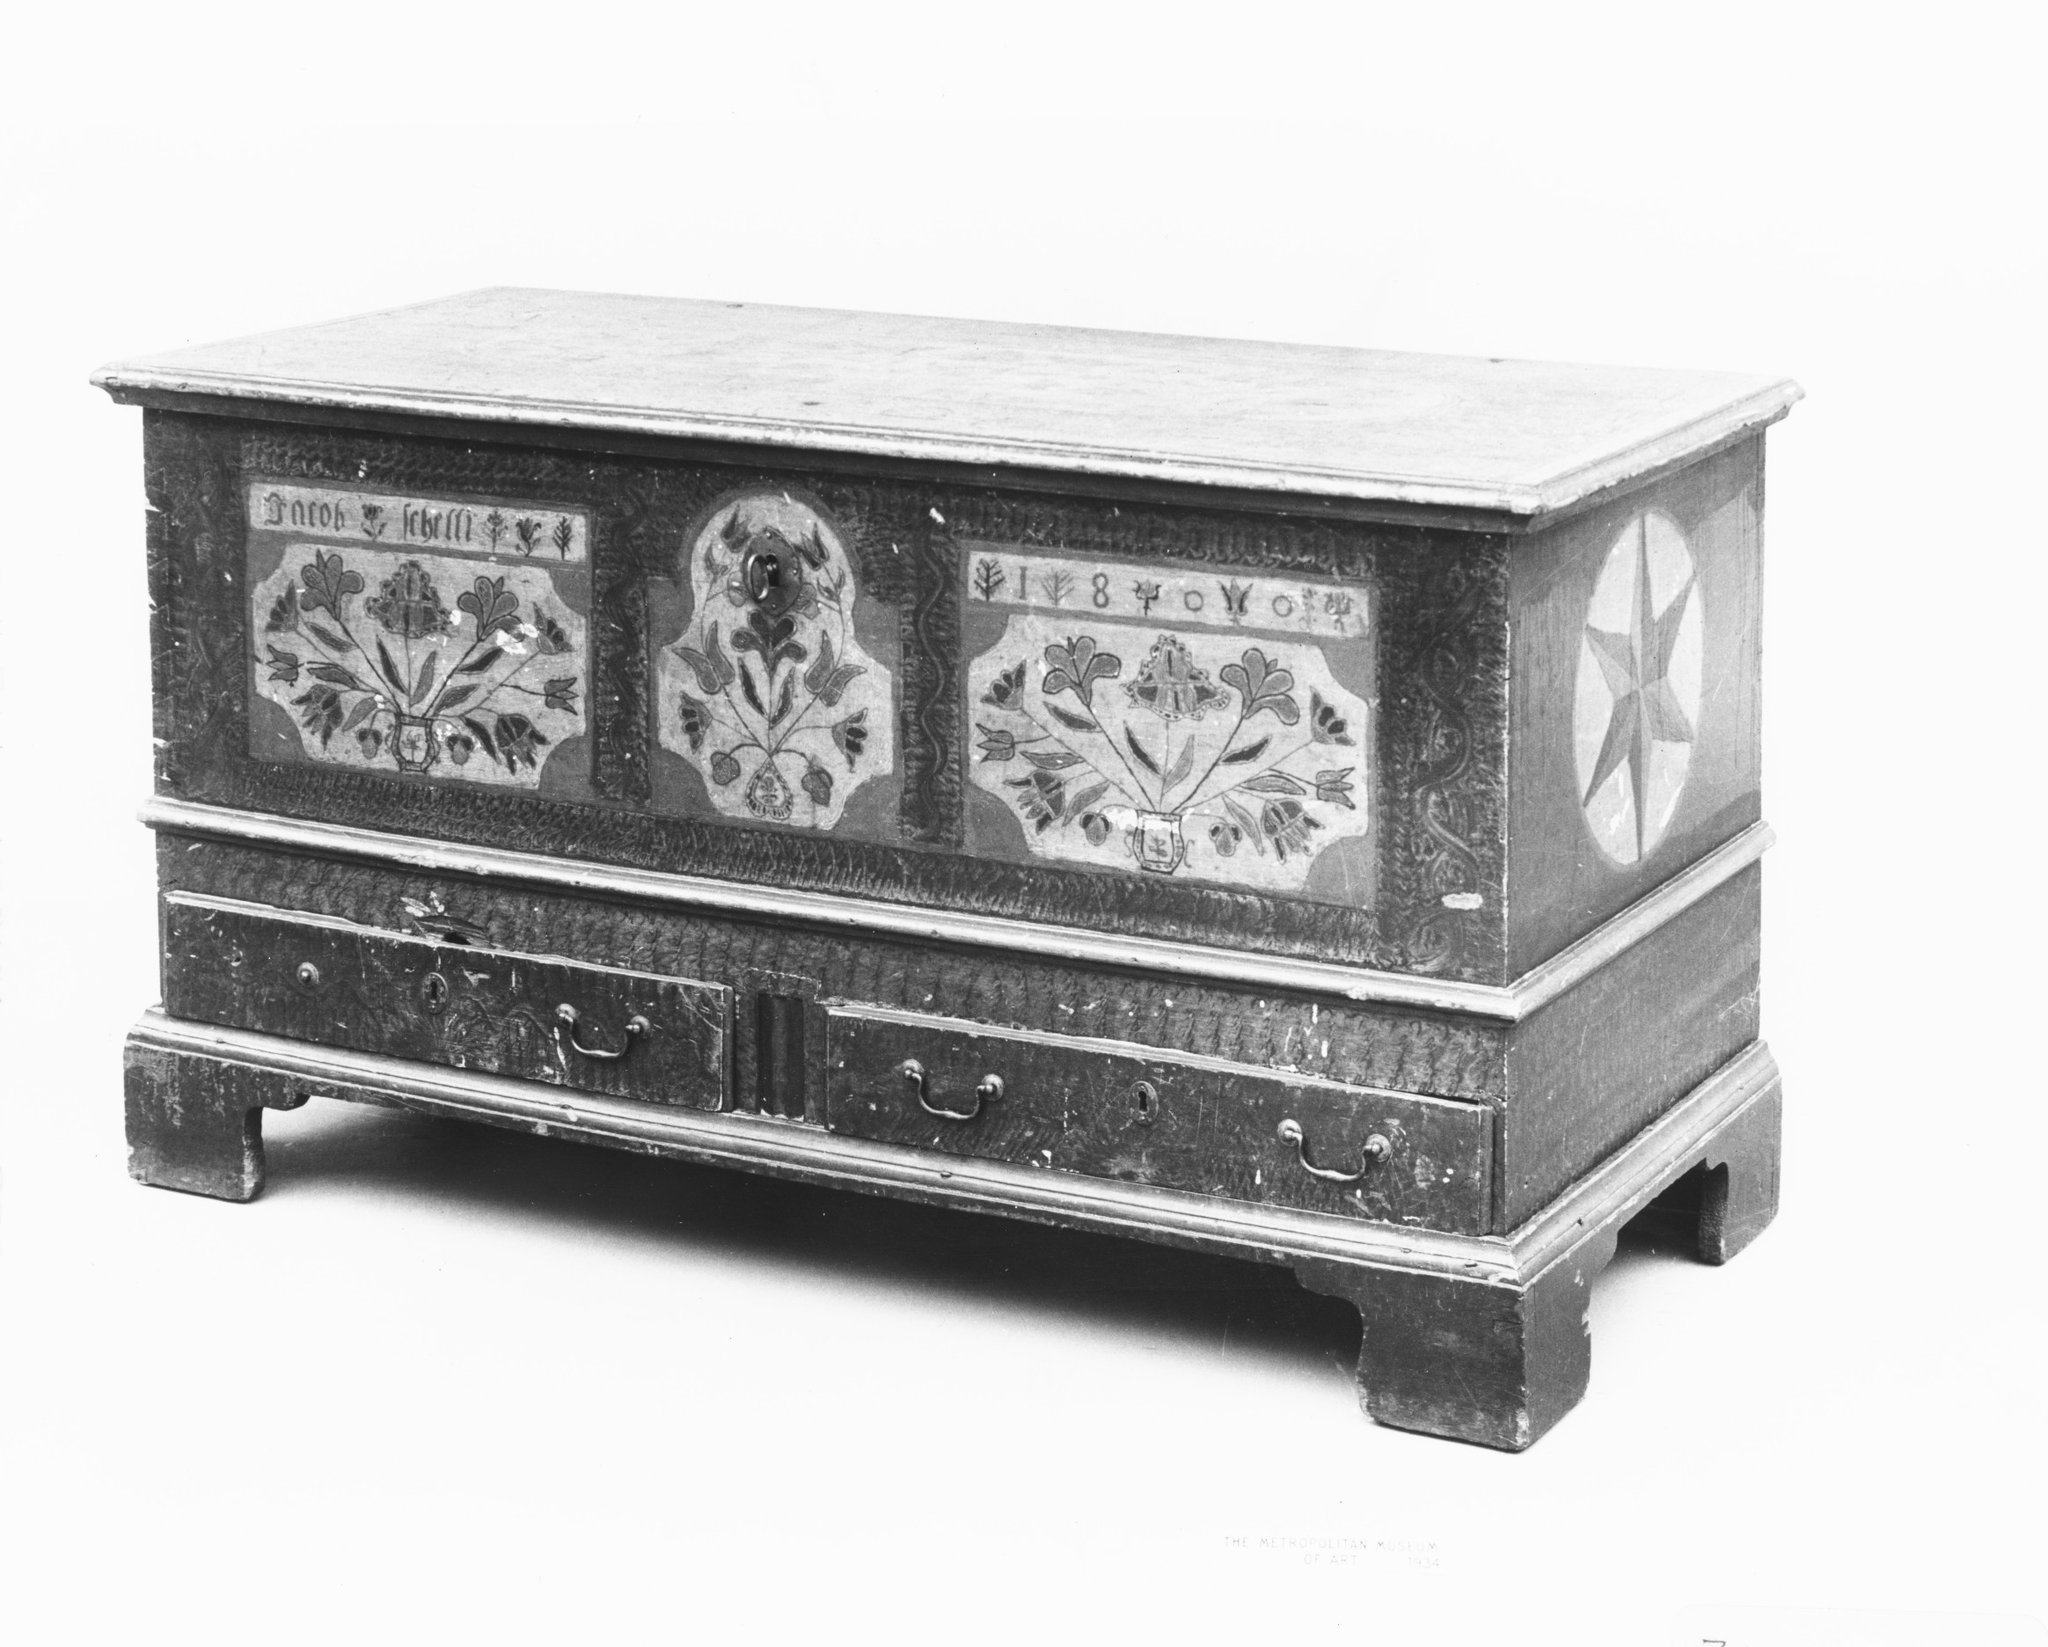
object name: dower chest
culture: american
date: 1800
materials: wood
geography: united states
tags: flowers